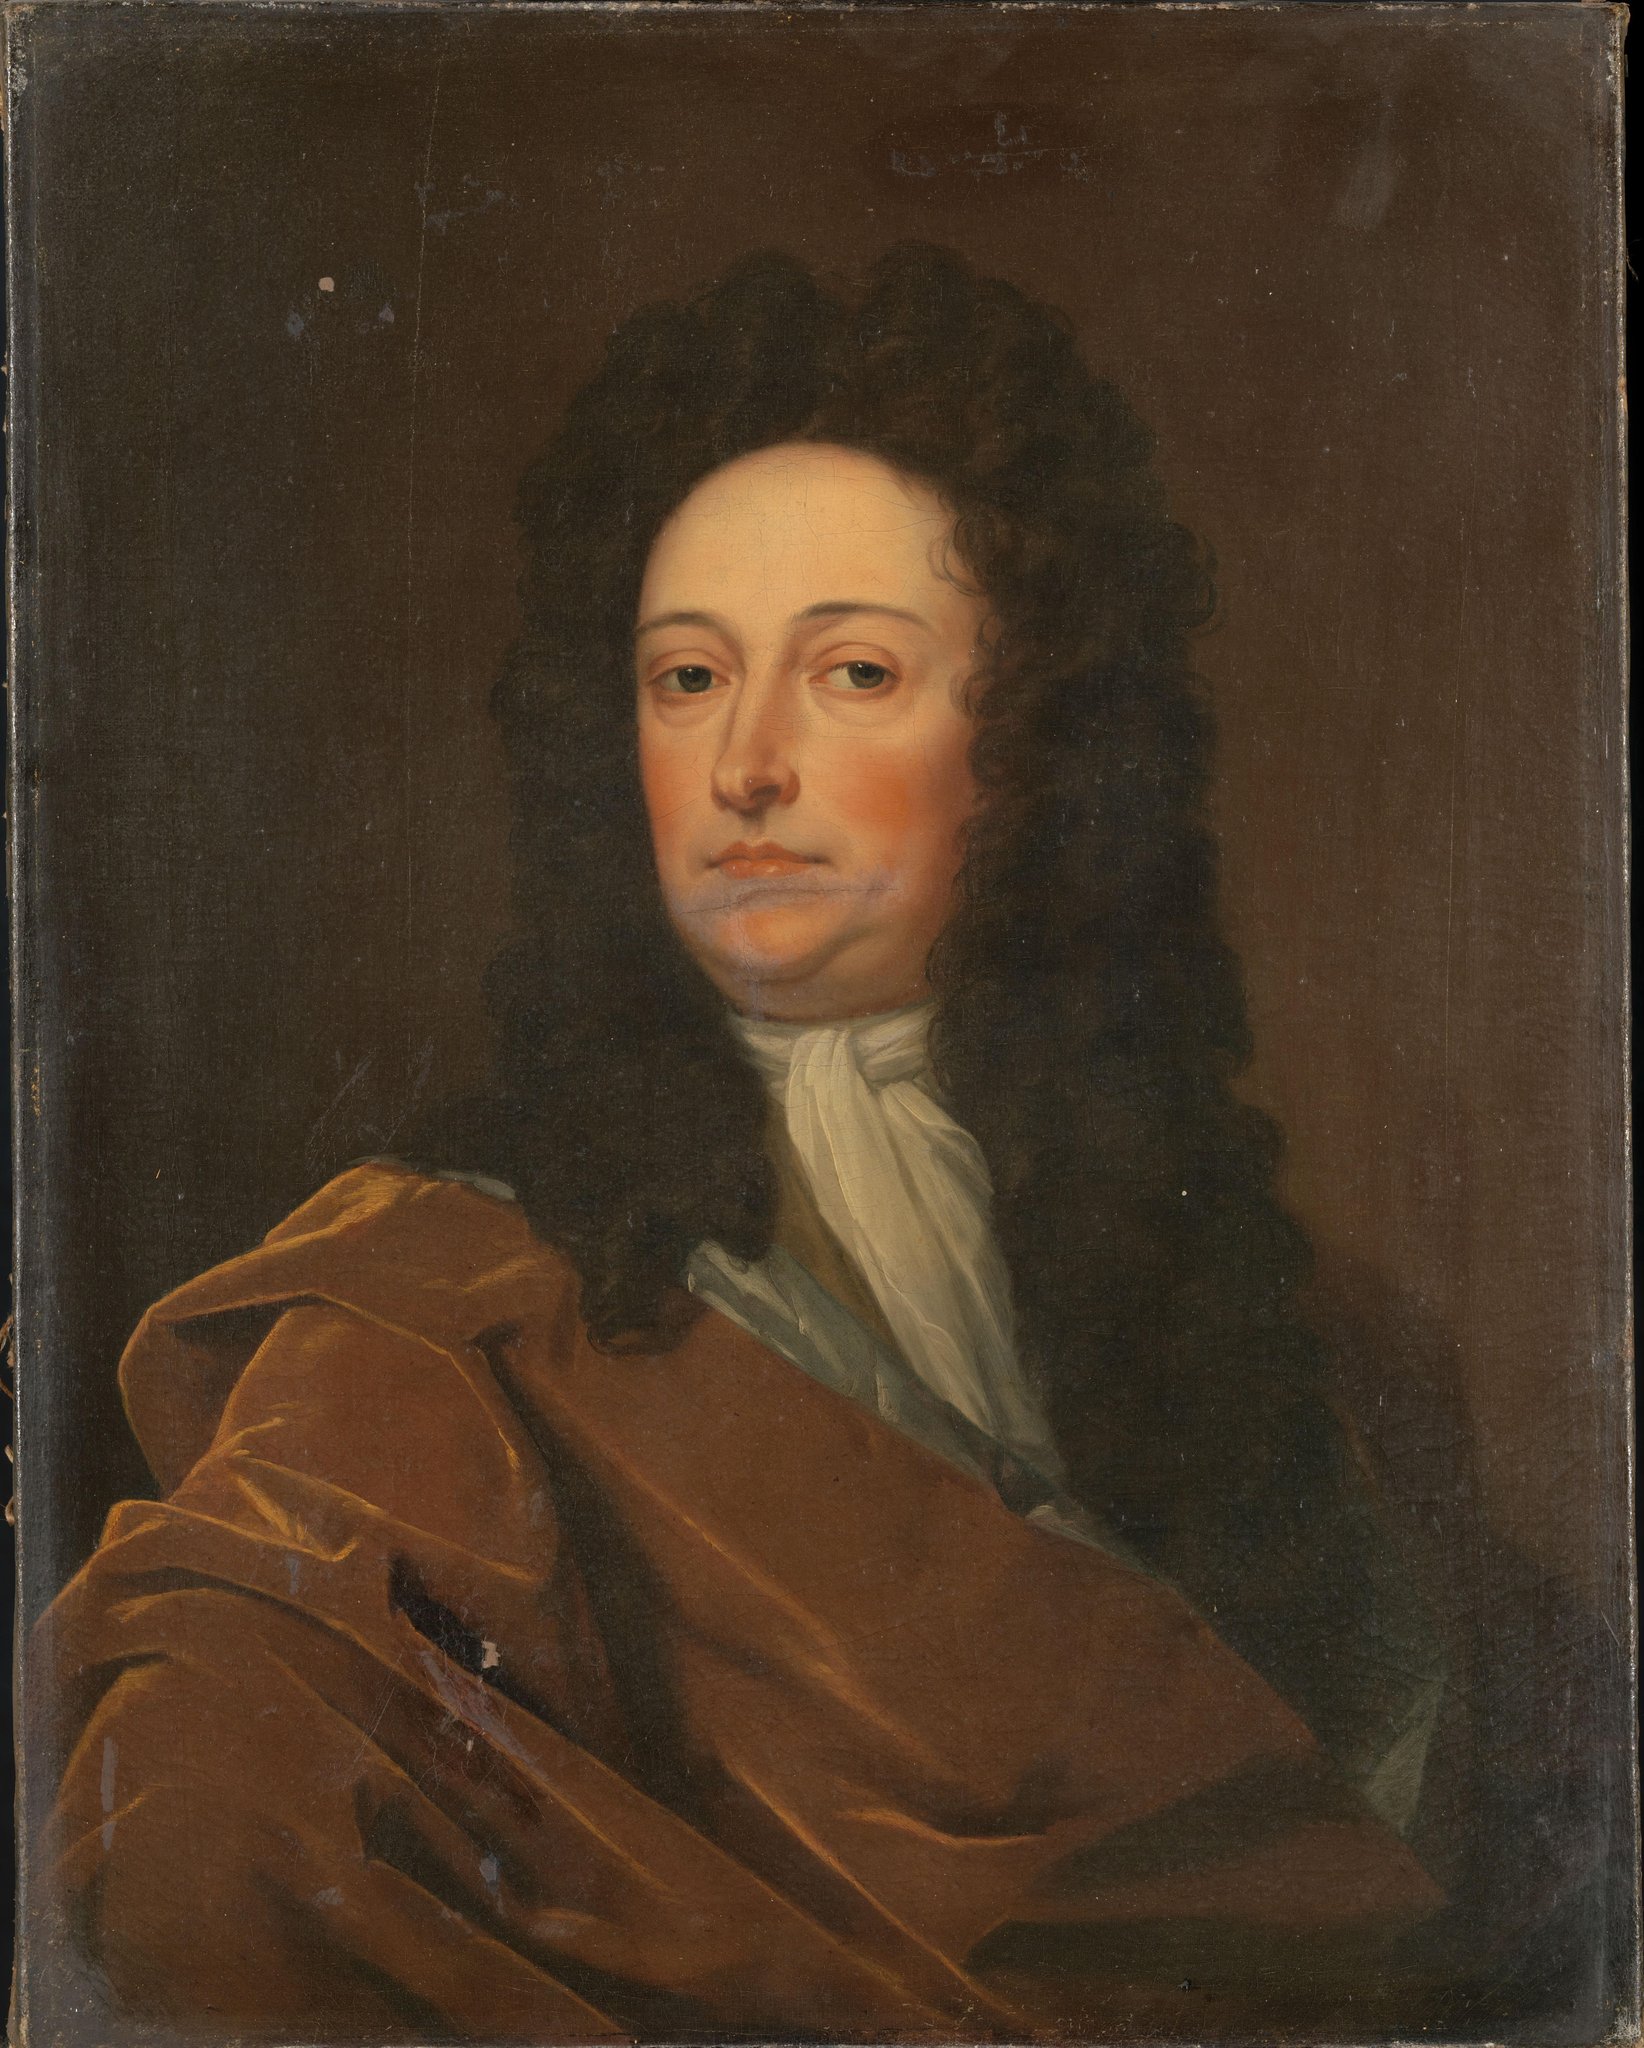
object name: painting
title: Aernout van Citters (1633-96), Ambassador of the Dutch Republic in London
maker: philip van dijk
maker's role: draughtsman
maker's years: 1683-1753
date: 1700-1753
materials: canvas, oil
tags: historical persons, ambassador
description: Portret van Aernout van Citters, ambassadeur van de Republiek der Verenigde Nederlanden te Londen. Buste, iets naar links gedraaid. Kopie door Philip van Dijk naar het origineel van Kneller uit 1692 in Den Haag.